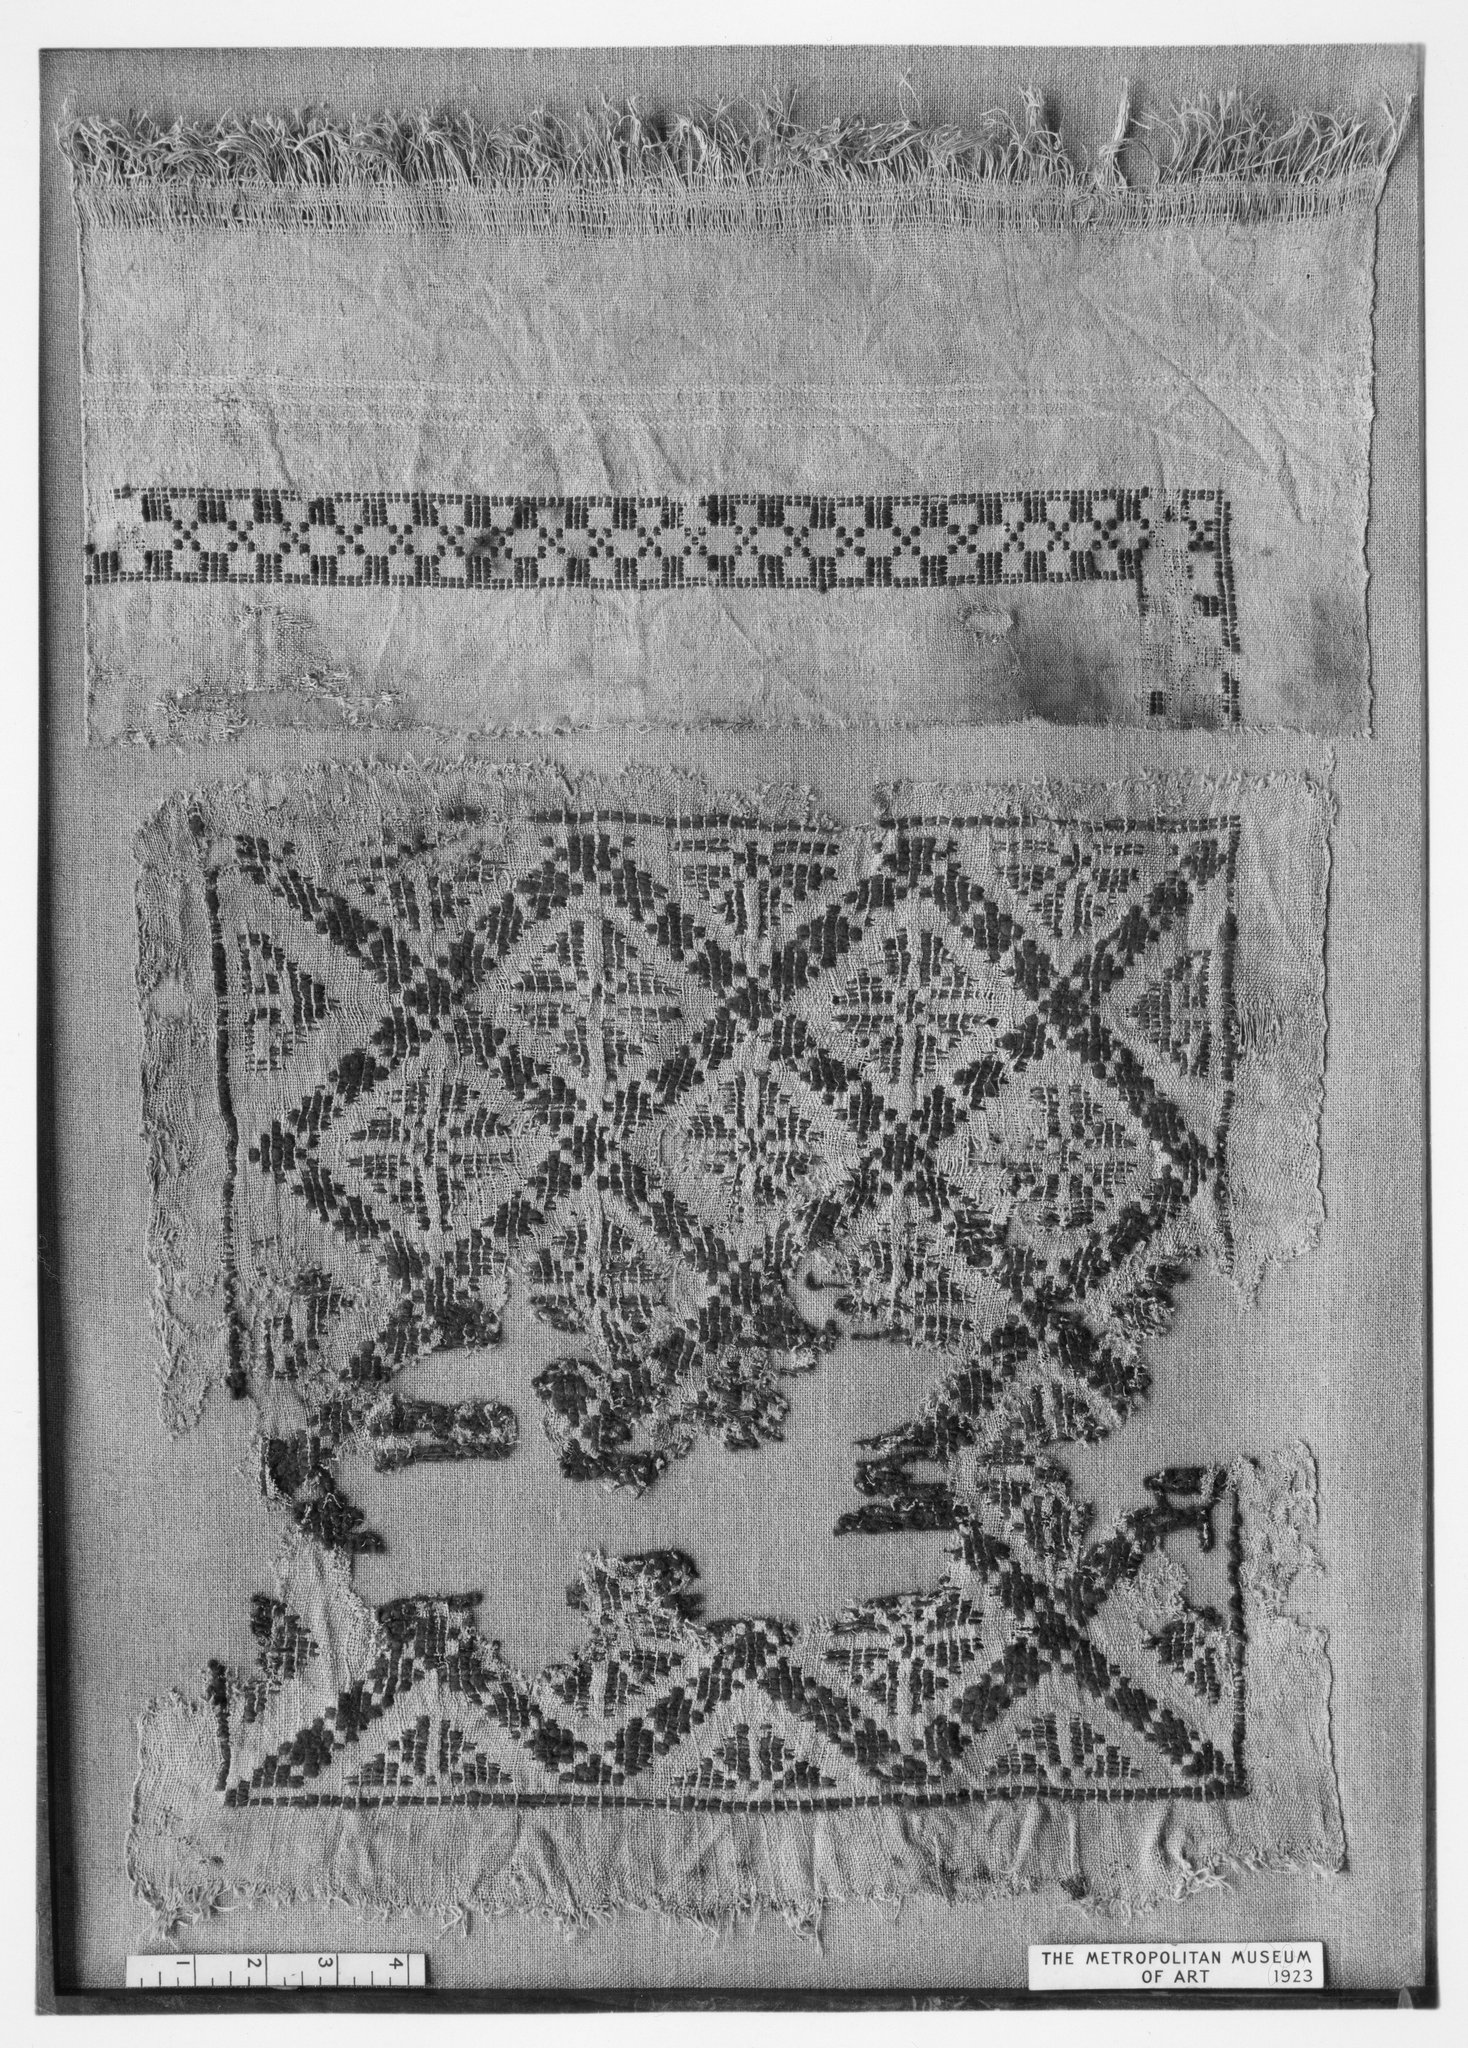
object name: tunic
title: Tunic with Interlace Decoration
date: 301-800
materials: linen, wool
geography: egypt